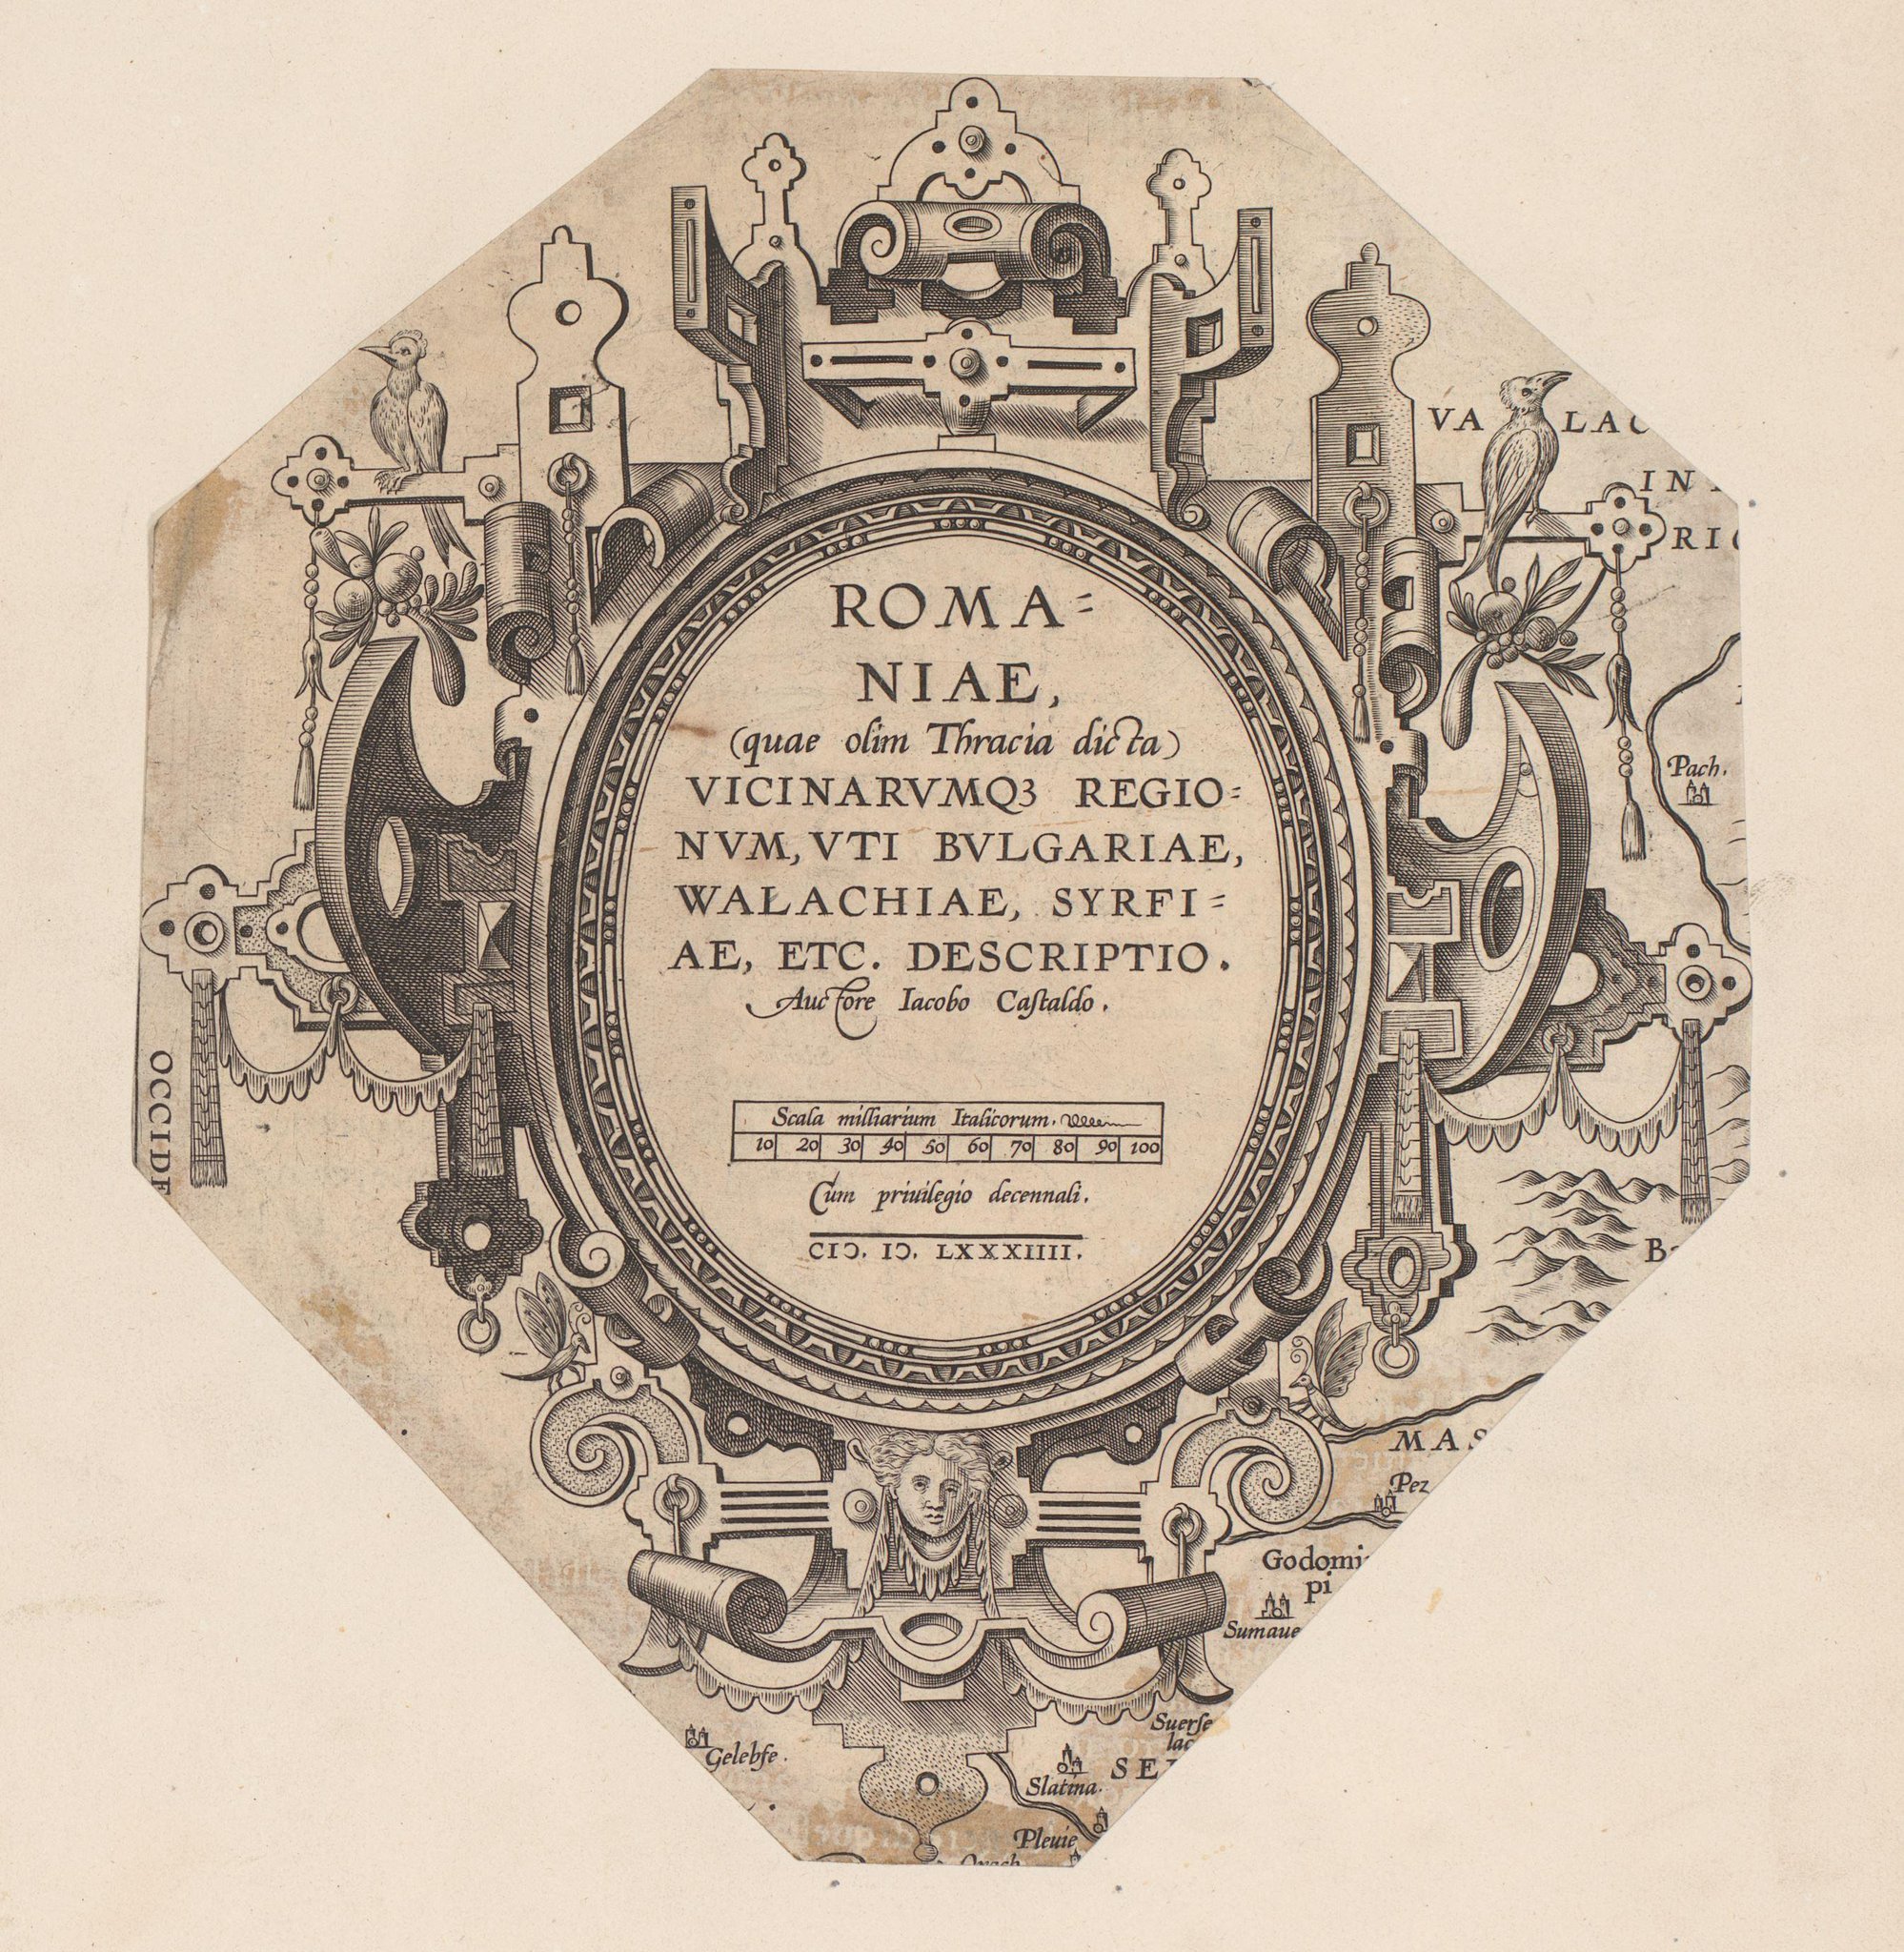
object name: album leaf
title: Staande ovale cartouche met twee vogels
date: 1584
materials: paper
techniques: engraving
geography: antwerp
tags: fruits and vegetables ~ ornament, scrollwork, strapwork ~ ornament, birds, ornament ~ cartouche, mask, mascaron ~ ornament, insects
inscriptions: collector's mark: Lugt 2166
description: Staande ovale rolwerkcartouche gedecoreerd met twee vogels, twee vlinders en een mascaron. De cartouche is een fragment van een kaart van Roemenië en omliggende regio's. De prent maakt deel uit van een album.